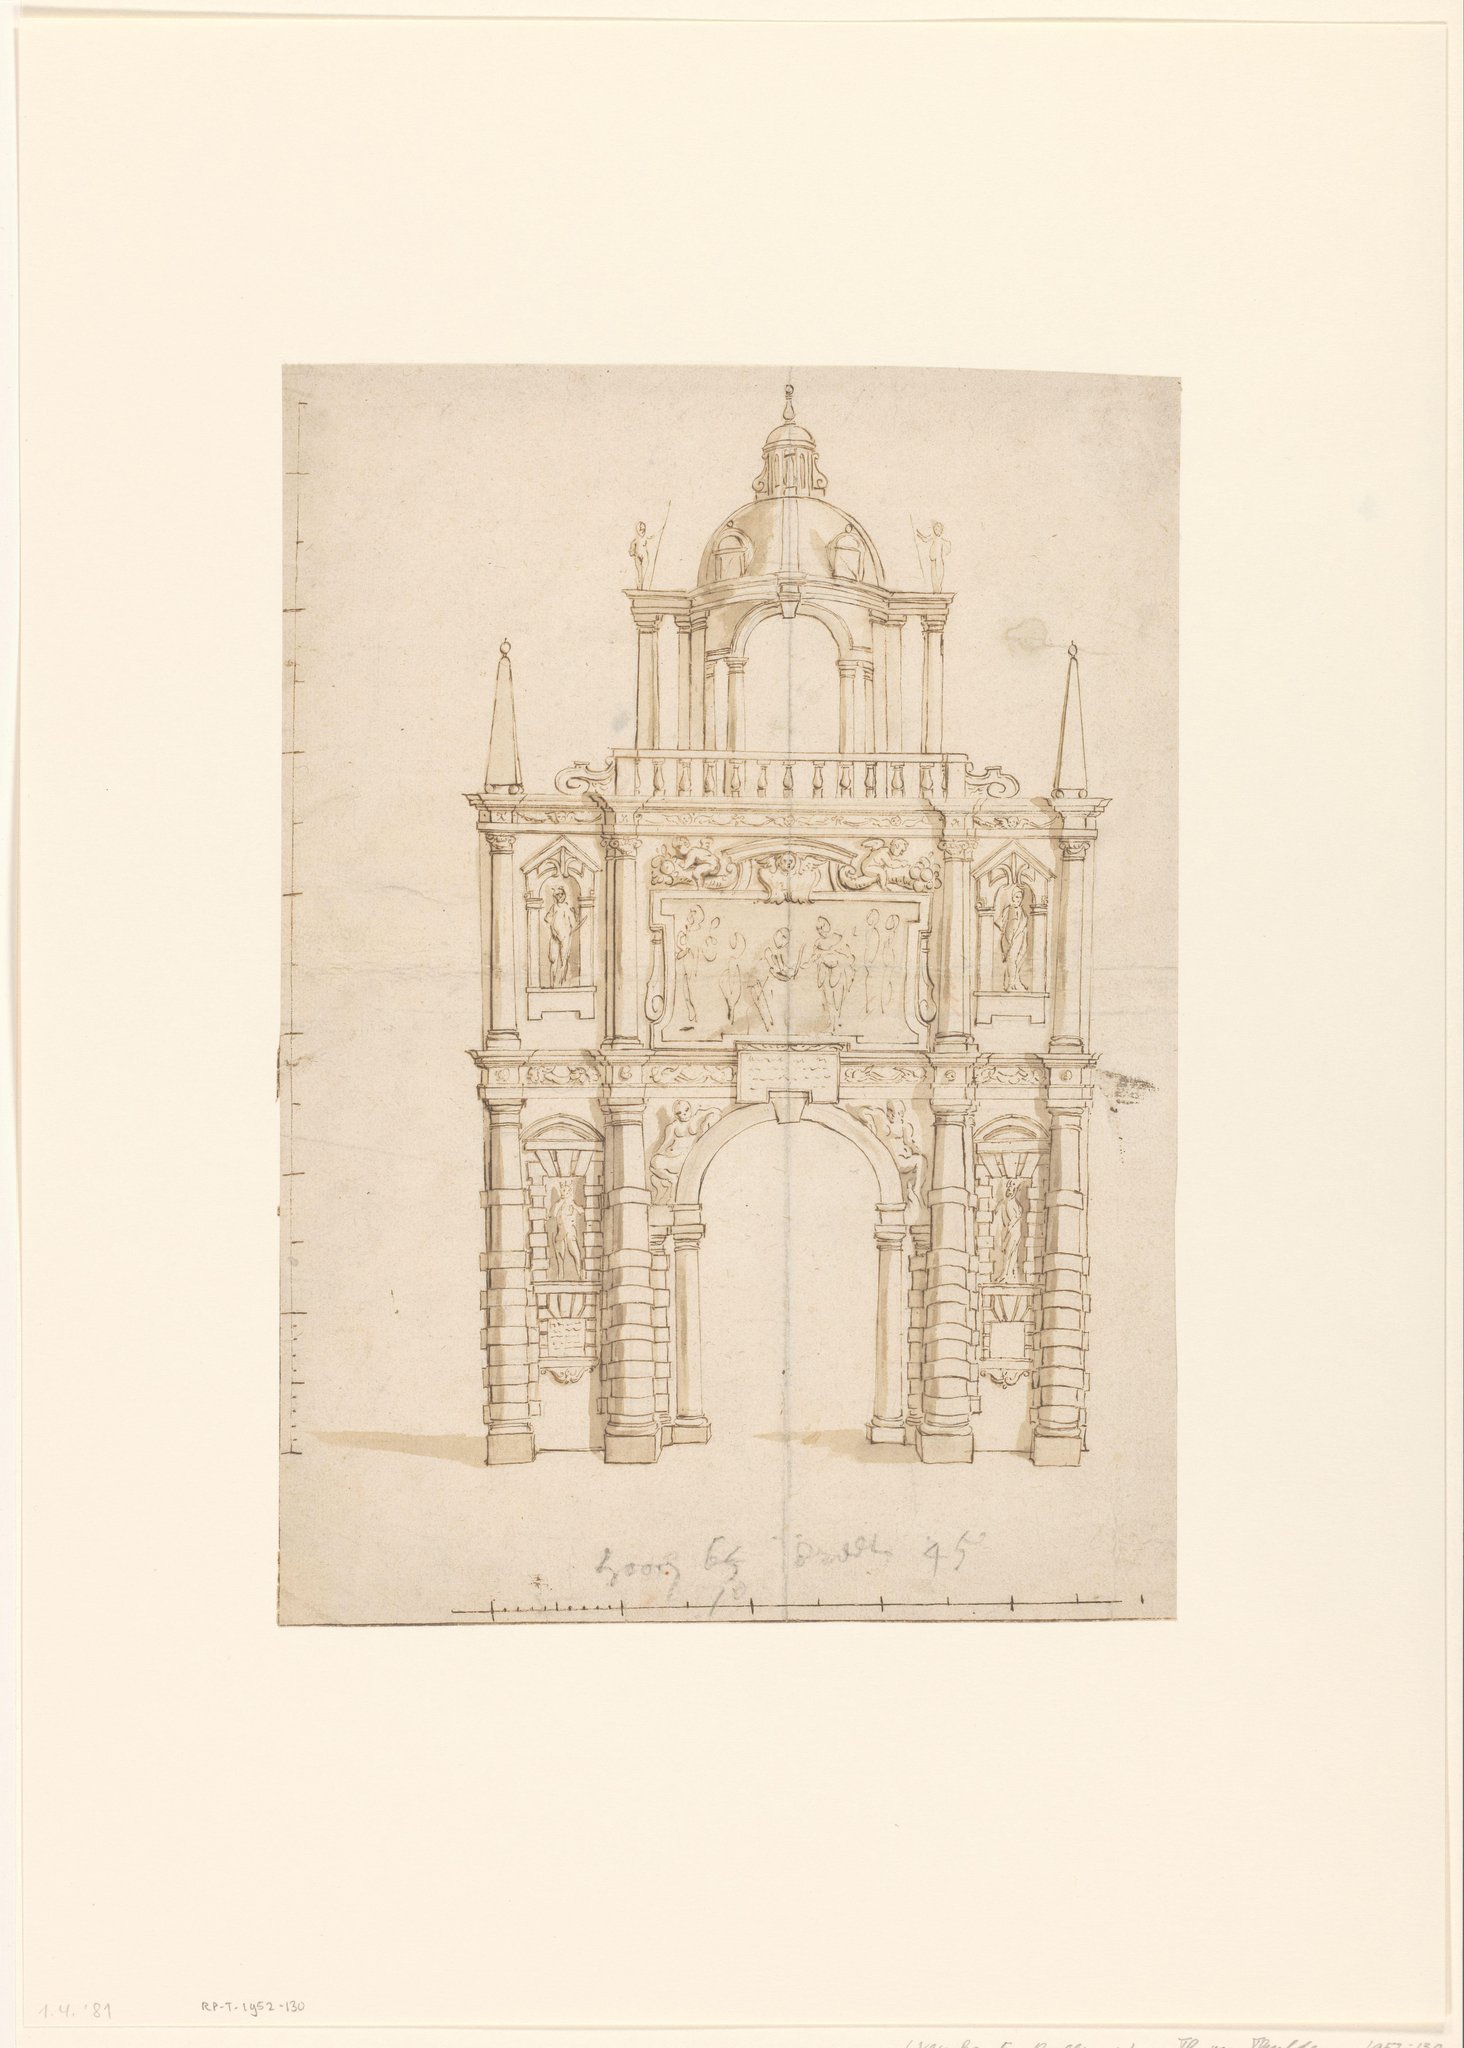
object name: drawing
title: Ontwerp voor een ereboog voor aartshertog Leopold Willem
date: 1646-1648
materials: ink, paper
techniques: brush, pen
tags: vienna, leopold willem van oostenrijk (landvoogd der zuidelijke nederlanden), triumphal arch